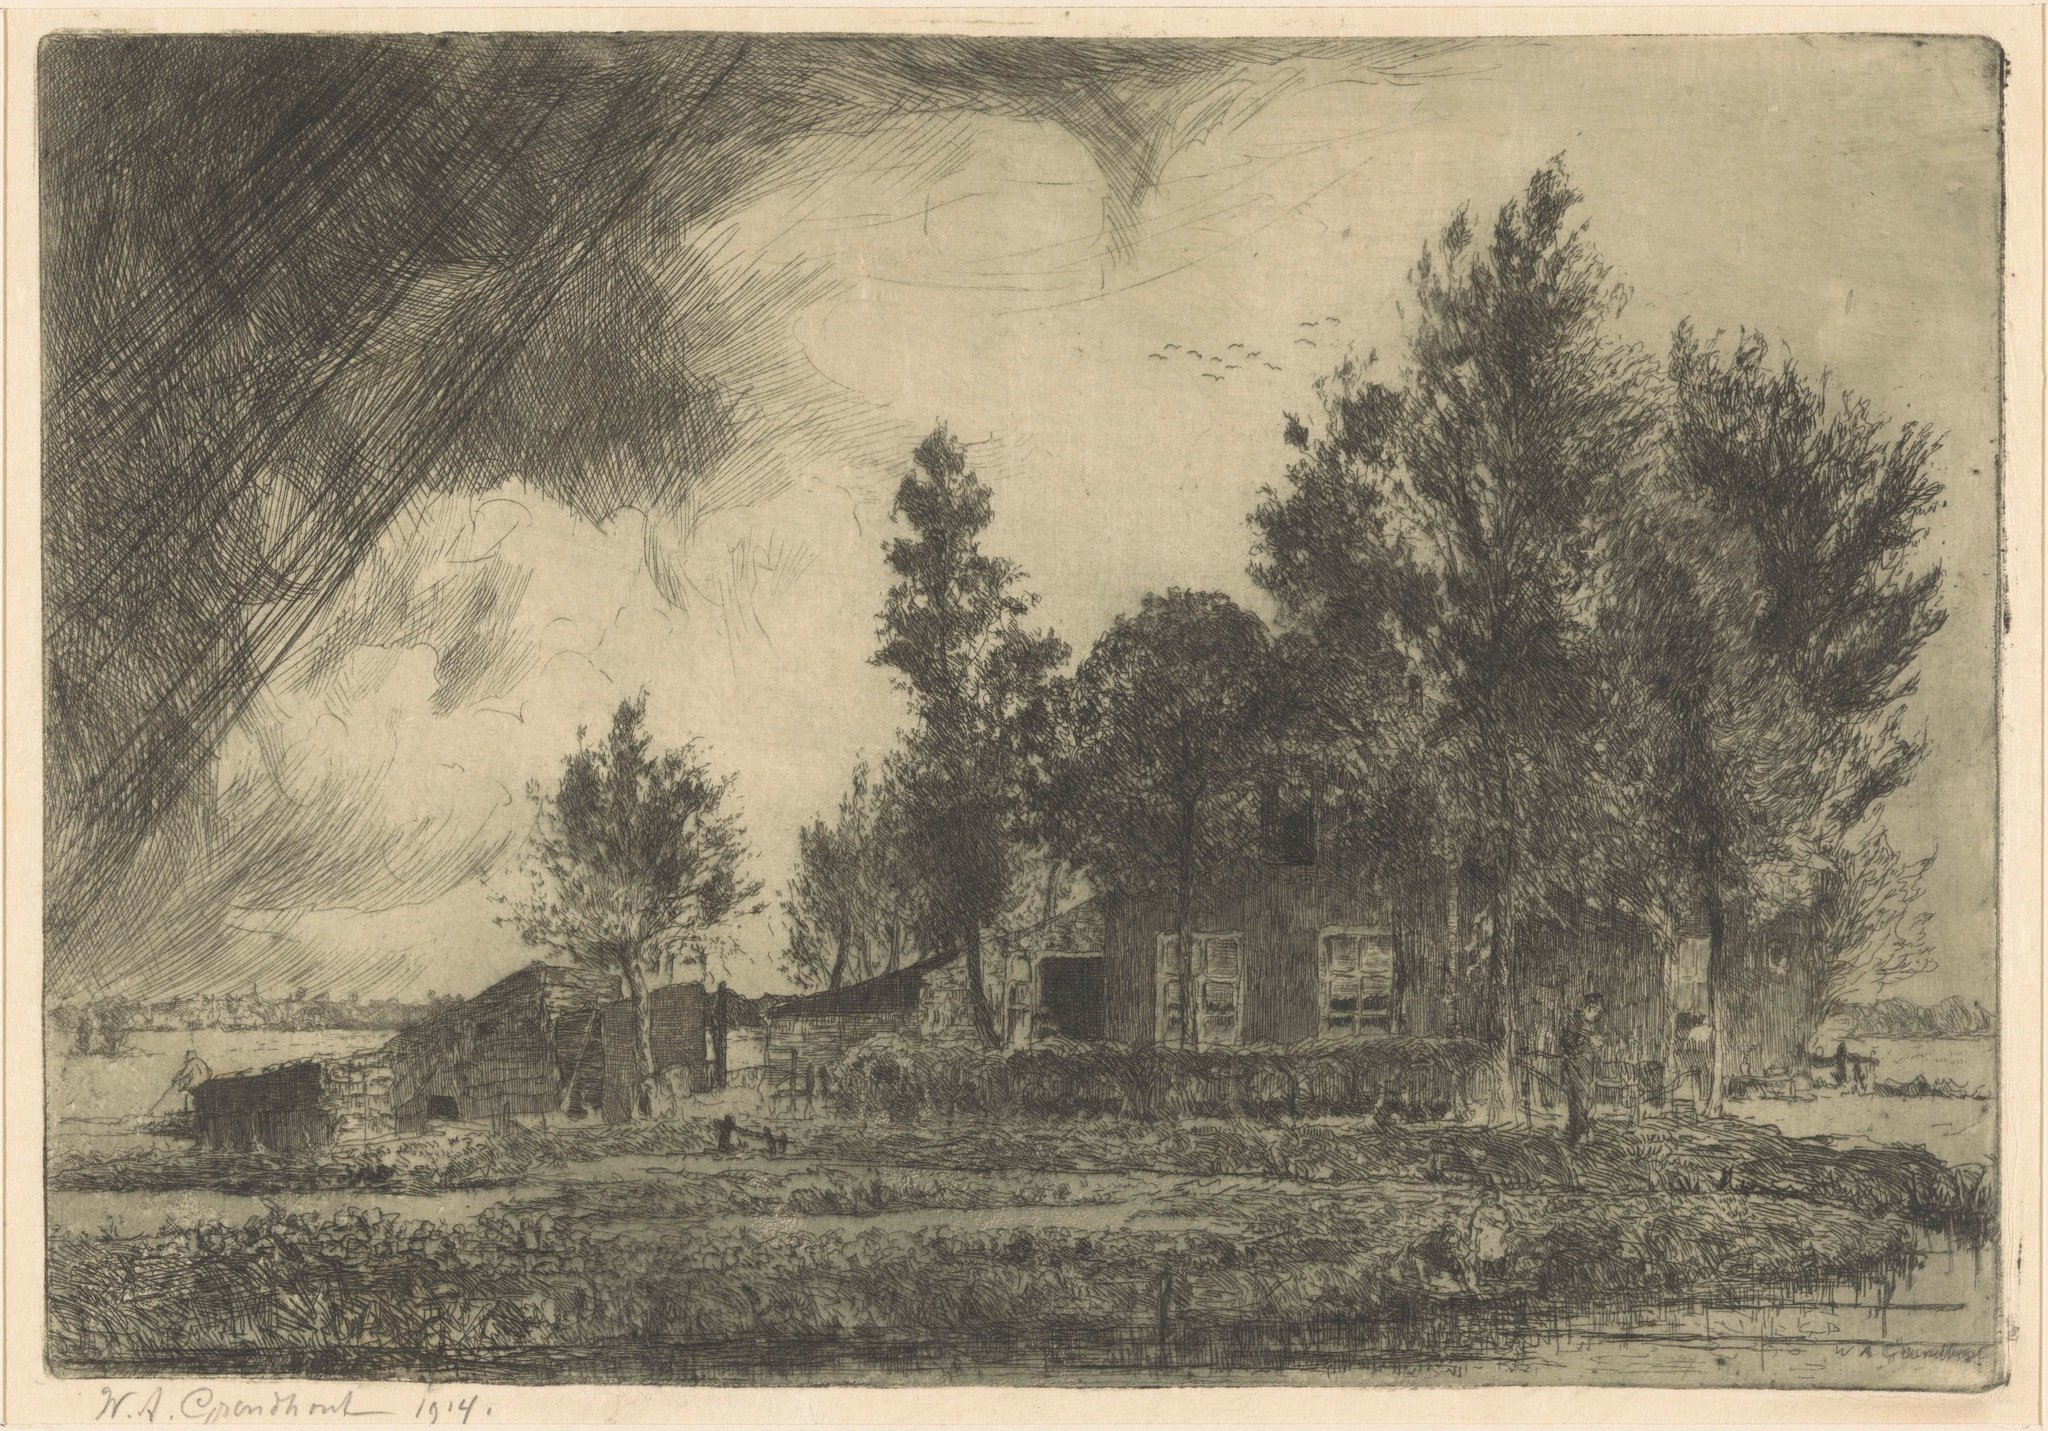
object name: print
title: Boerderij bij Voorburg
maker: willem adrianus grondhout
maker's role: draughtsman, painter, print maker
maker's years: 1878-1934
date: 1914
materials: paper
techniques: etching, intaglio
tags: farm or solitary house in landscape, voorburg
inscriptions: collector's mark: Lugt 2228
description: Een boerderij en de omliggende tuin aan het water. De lucht is betrokken.